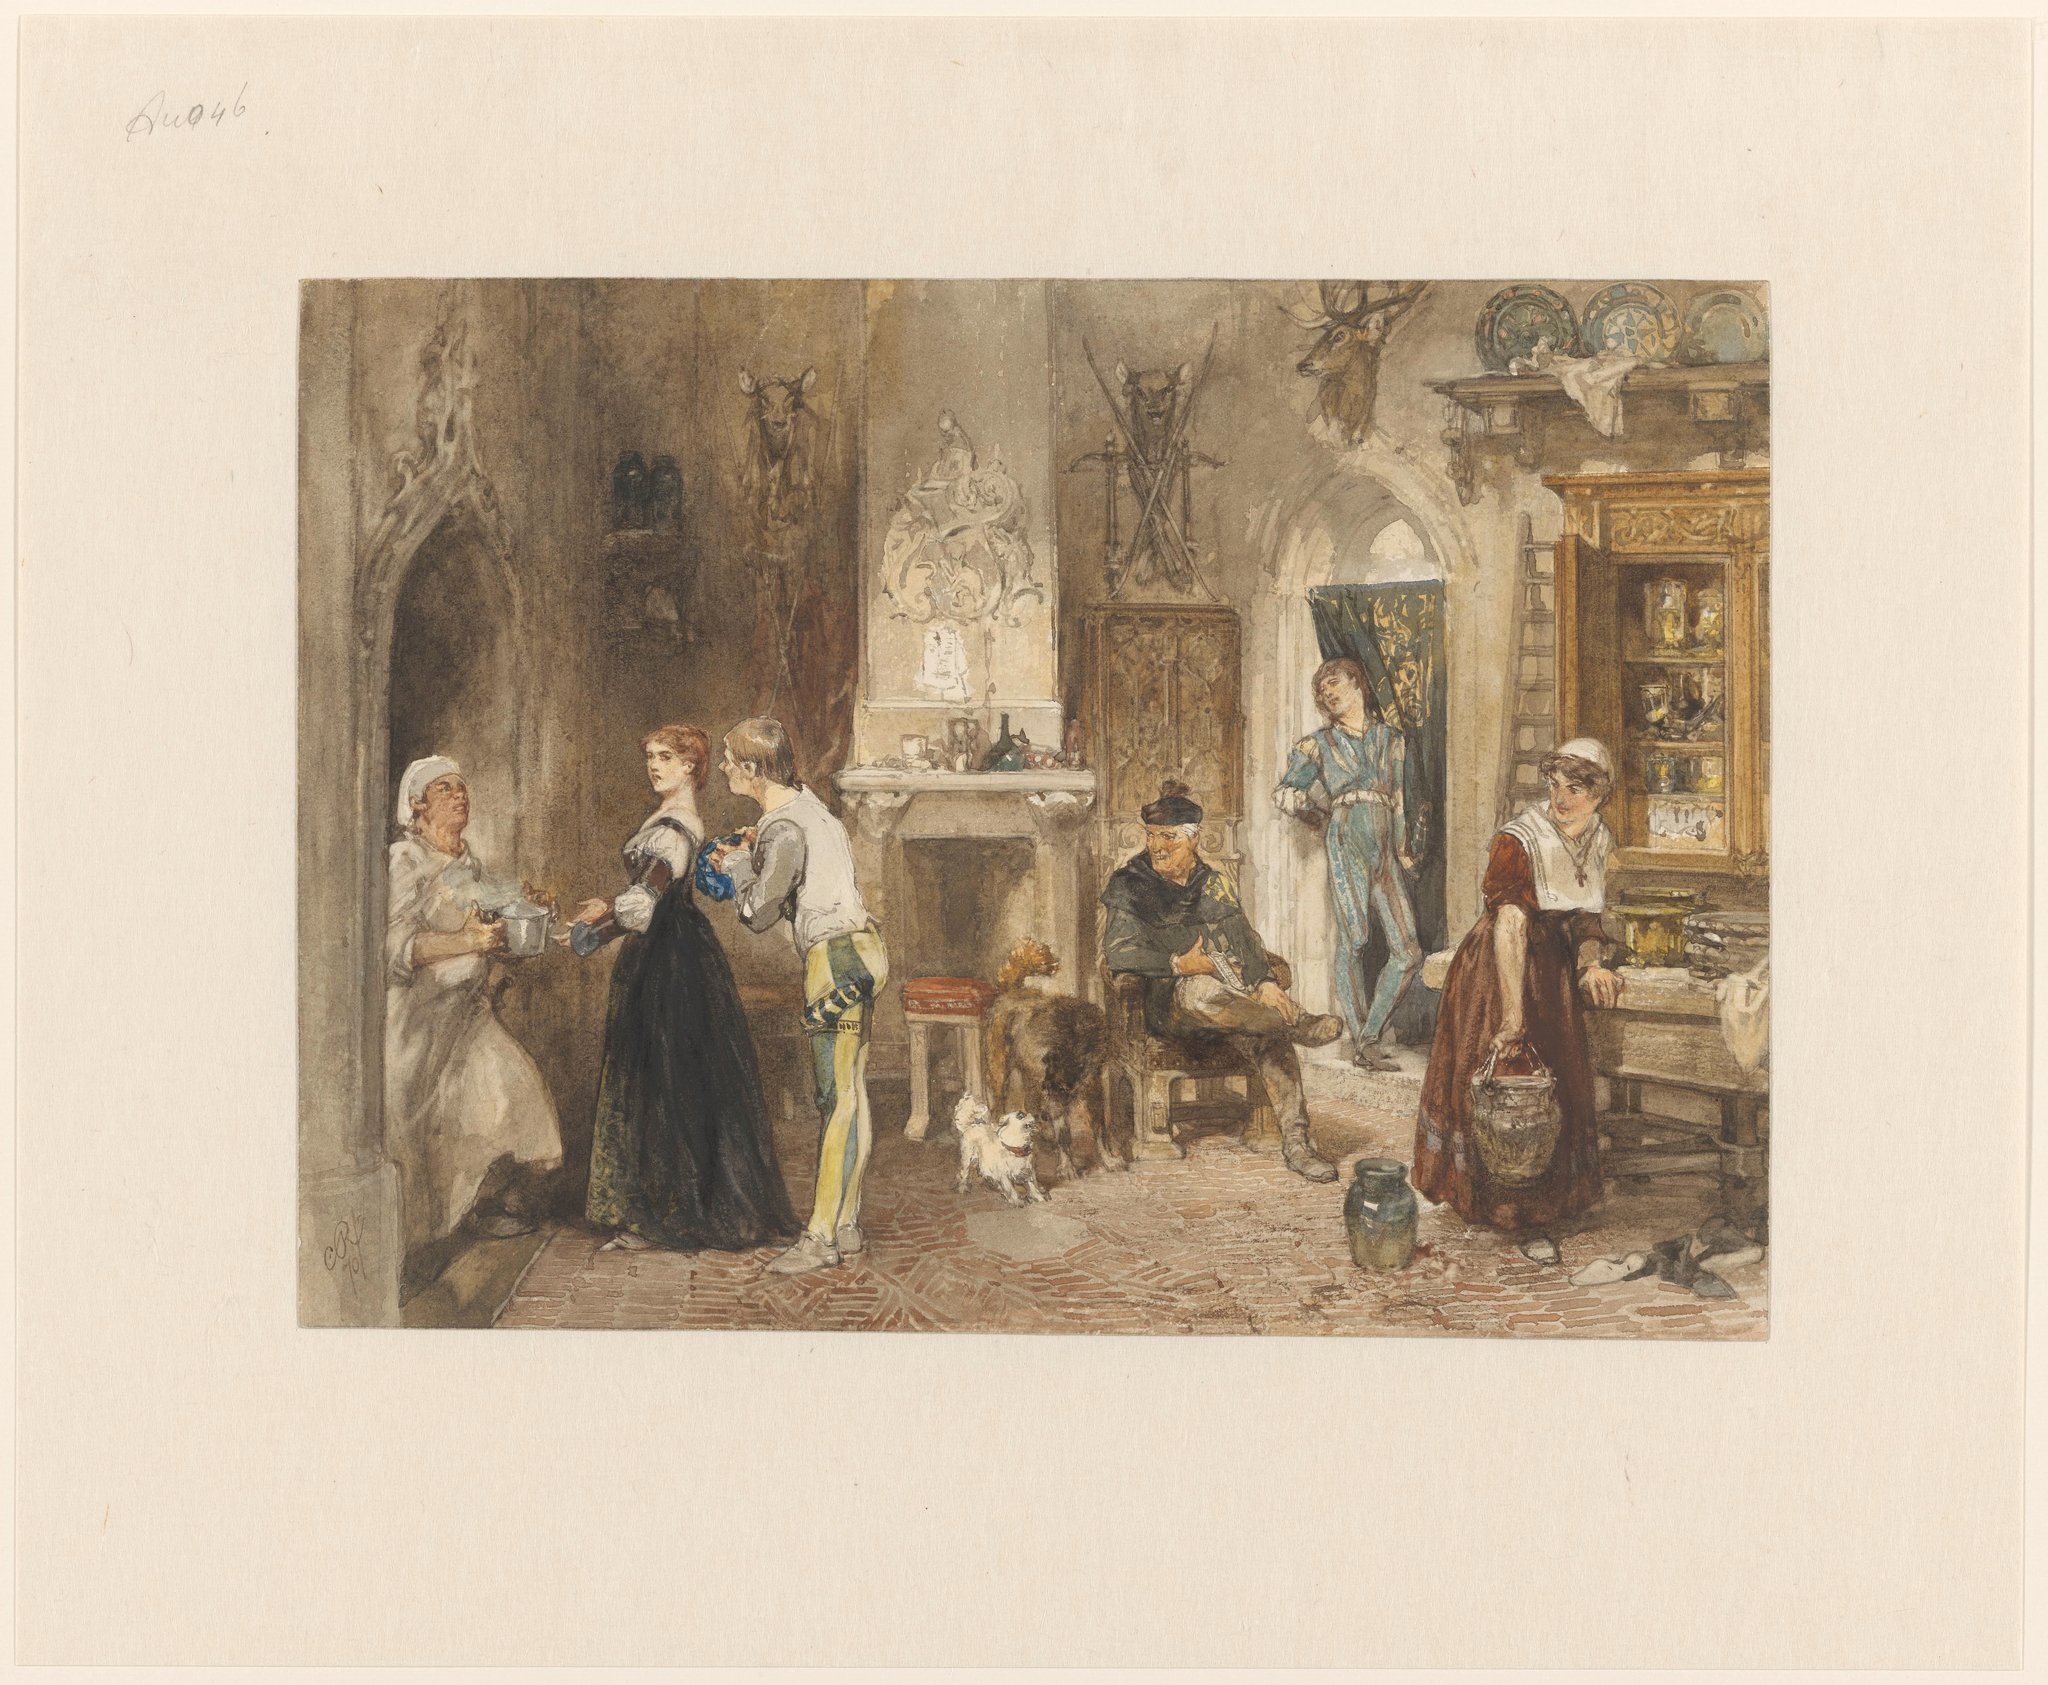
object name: drawing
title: Bedienden van een kasteel in een voorvertrek verenigd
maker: charles rochussen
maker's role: draughtsman, painter, print maker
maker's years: 1814-1894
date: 1870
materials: paper, watercolor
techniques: brush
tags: cook, communal rooms, eating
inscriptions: inscription: ‘Le bouillon de la Chatelaine’